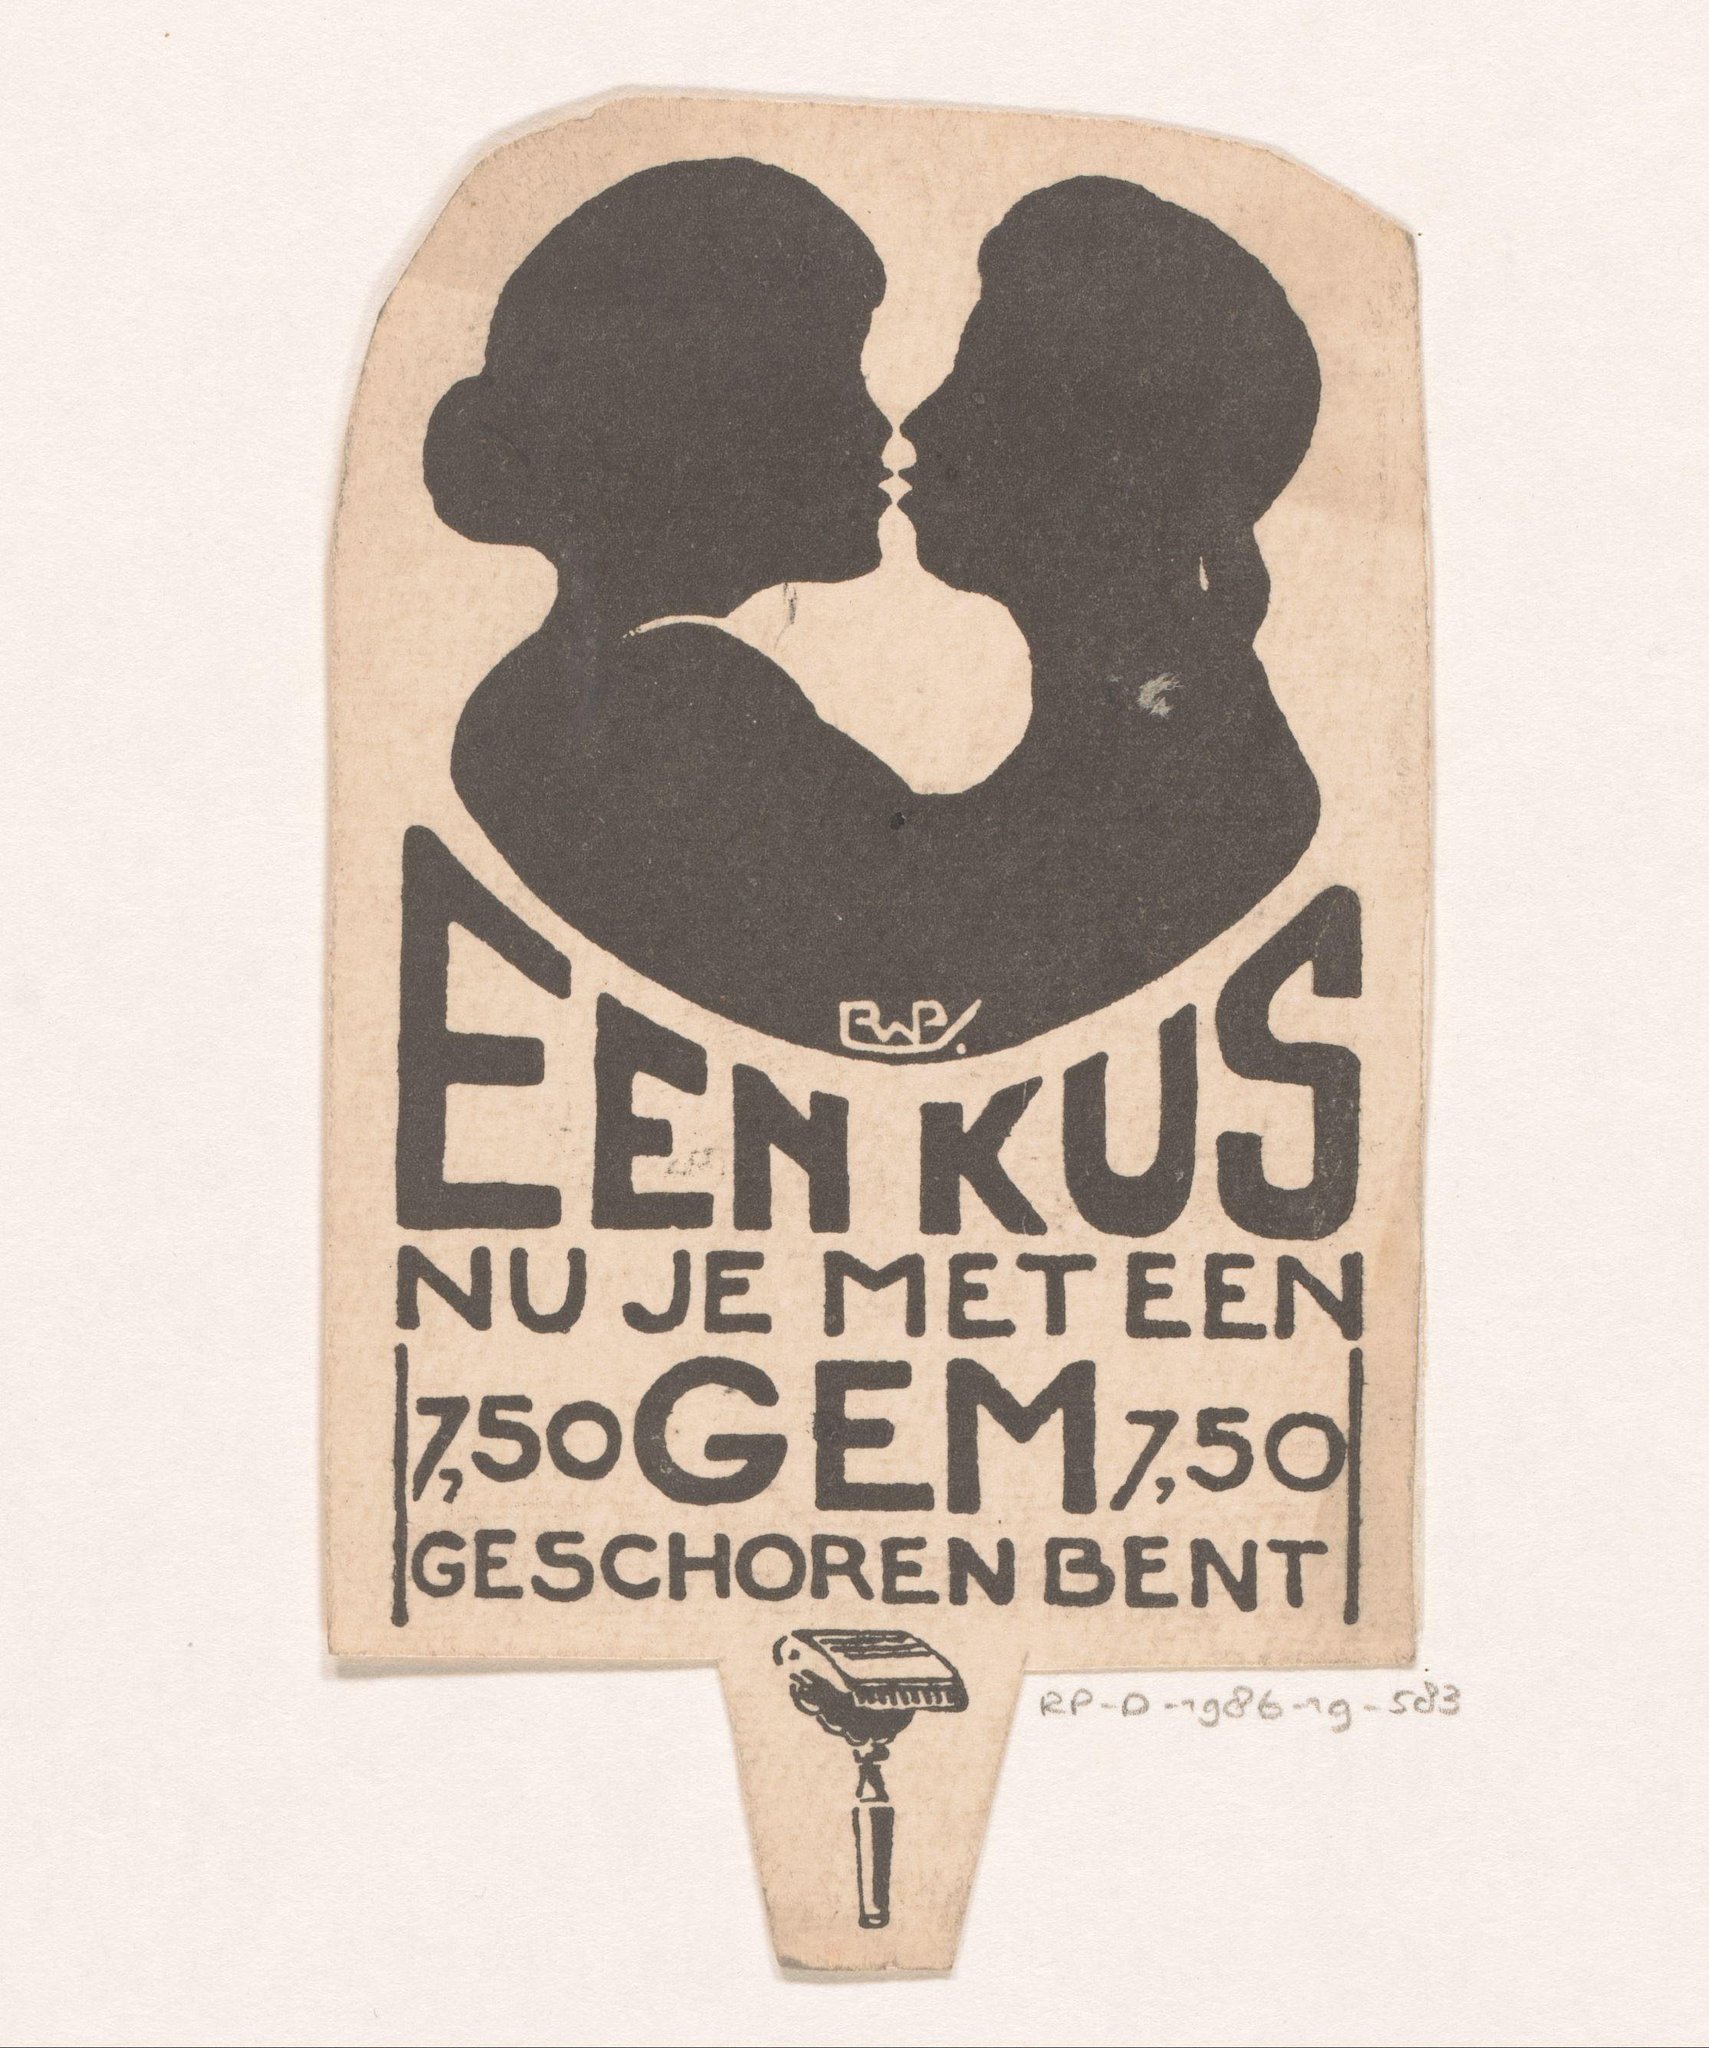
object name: photomechanical print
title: Advertentie voor GEM safety razor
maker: reinier willem petrus de vries (1874-1953)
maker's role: draughtsman, print maker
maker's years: 1874-1953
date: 1920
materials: paper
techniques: printing block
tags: razor, (lovers) kissing each other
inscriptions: collector's mark: ‘R:MVS.’, annotation: ‘14 x 8 112 x 10 =/ f11.20/ 9-’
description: Silhouetten van een kussend paar met daaronder tekst en een scheermes.